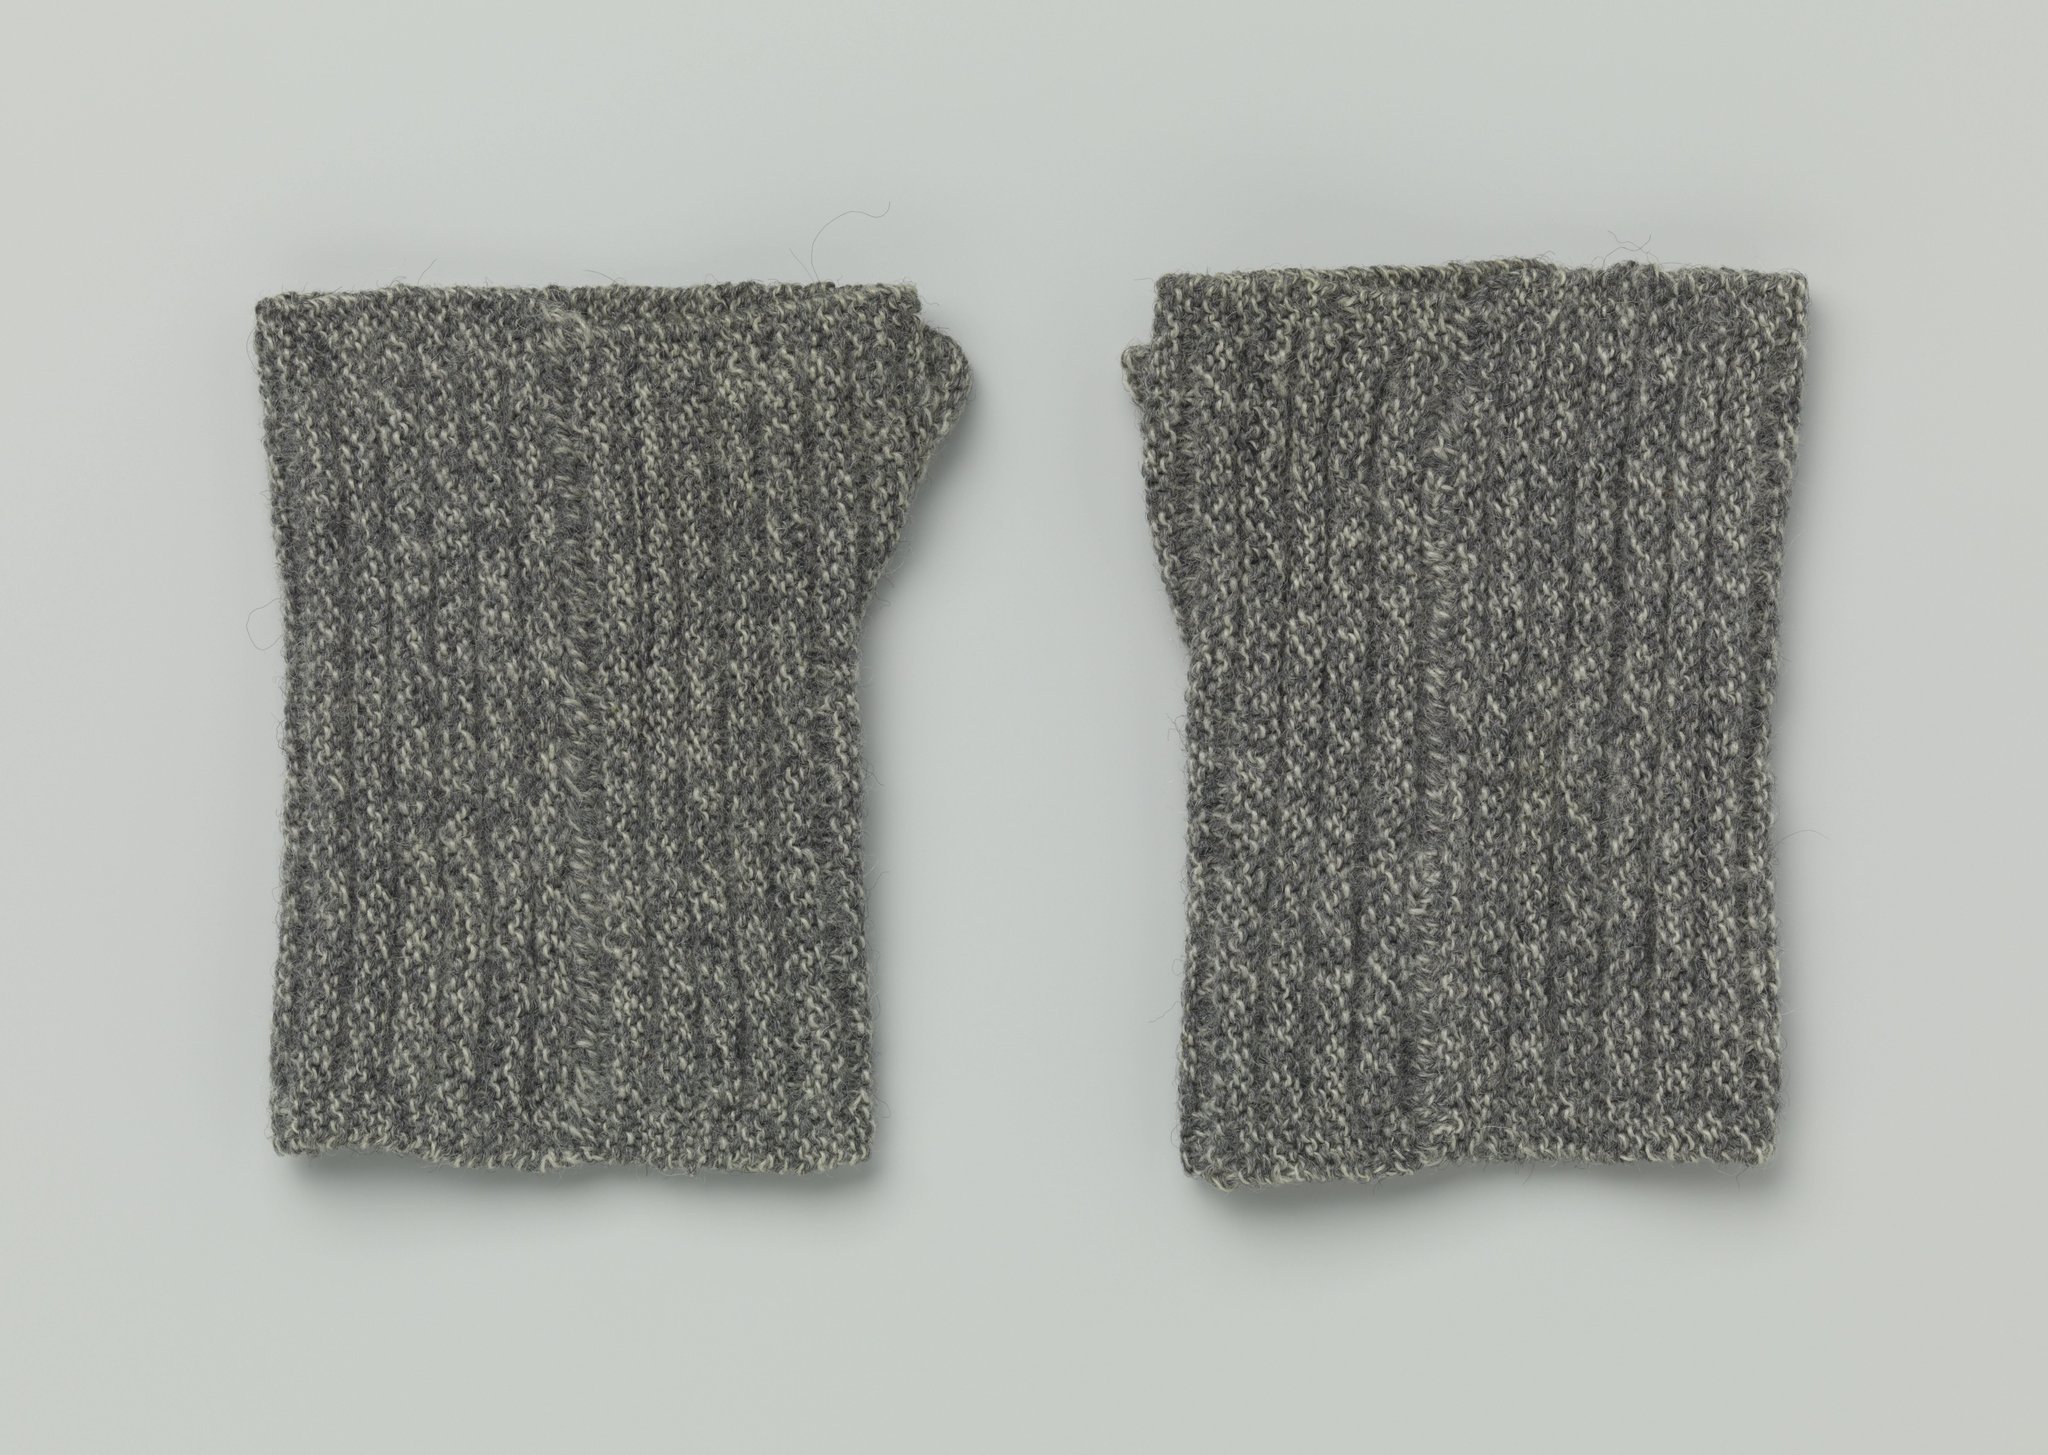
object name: mitt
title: Mitaine van grijswitte gemêleerde wol met duim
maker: Anonymous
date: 1900-1940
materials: wool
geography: western europe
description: Rechter mitiane van grijwitte gemêleerde wol met duim. Kort model. Deel van een paar.